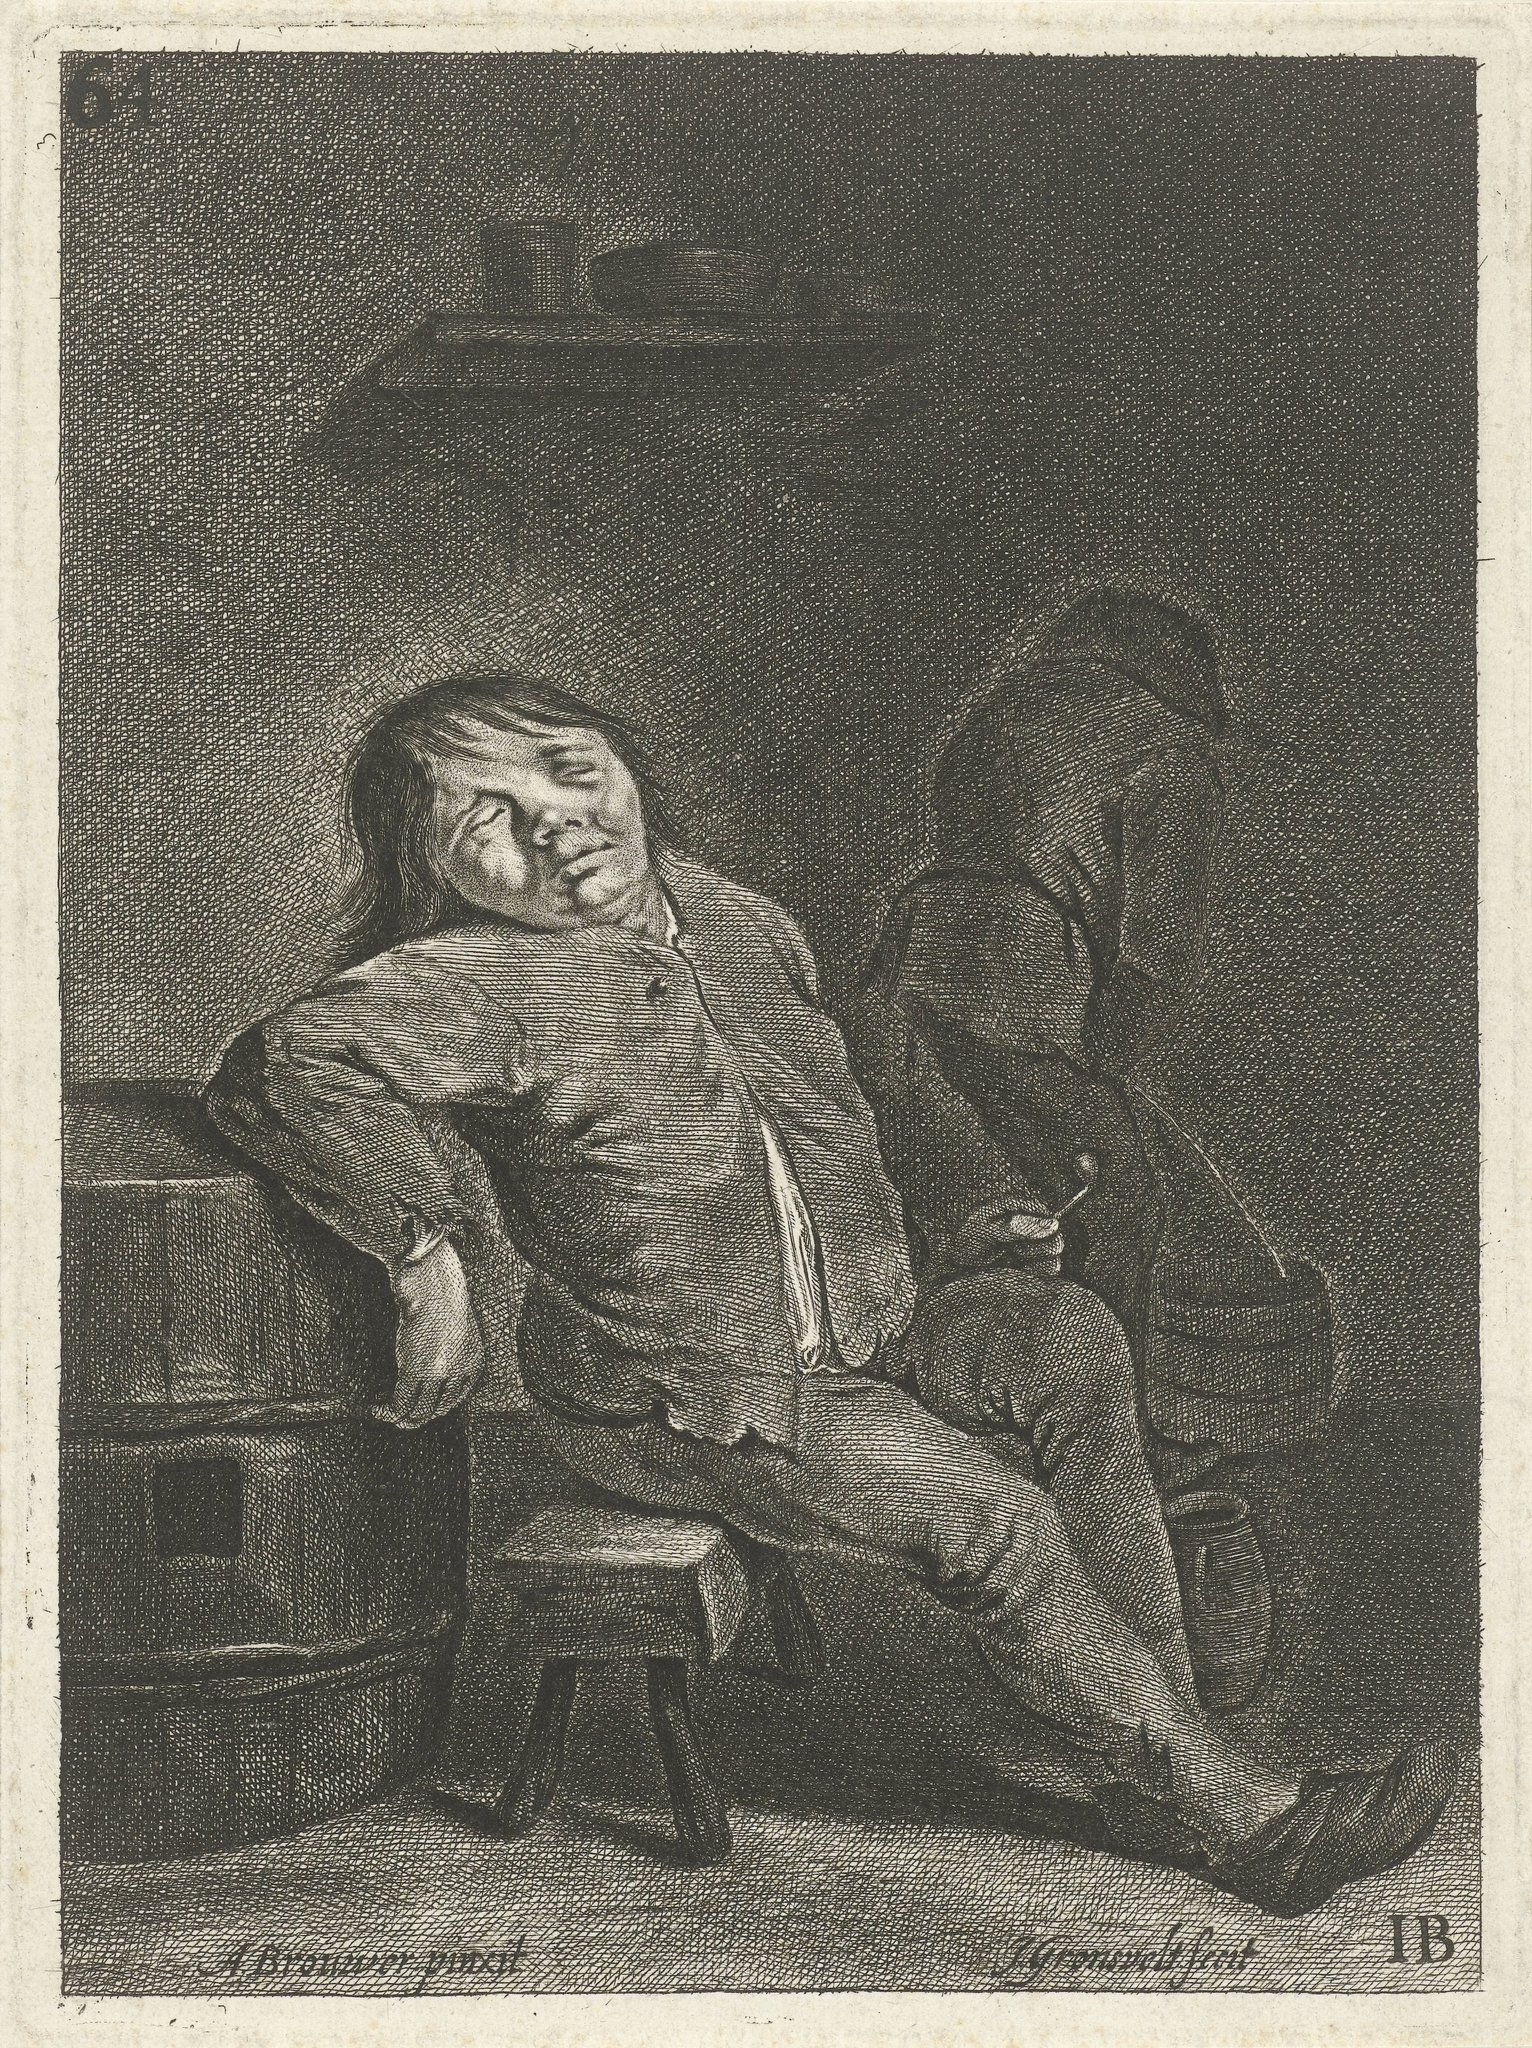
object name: print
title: Herberginterieur met twee boeren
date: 1679-1728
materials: paper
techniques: engraving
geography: amsterdam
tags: sleeping in chair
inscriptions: collector's mark: Lugt 1410, number: ‘64’, collector's mark: Lugt 2228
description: Herberginterieur met slapende boer op een kruk, leunend tegen een ton. In zijn linkerhand een pijp. Rechts een boer, op de rug gezien, plassend in een emmer.